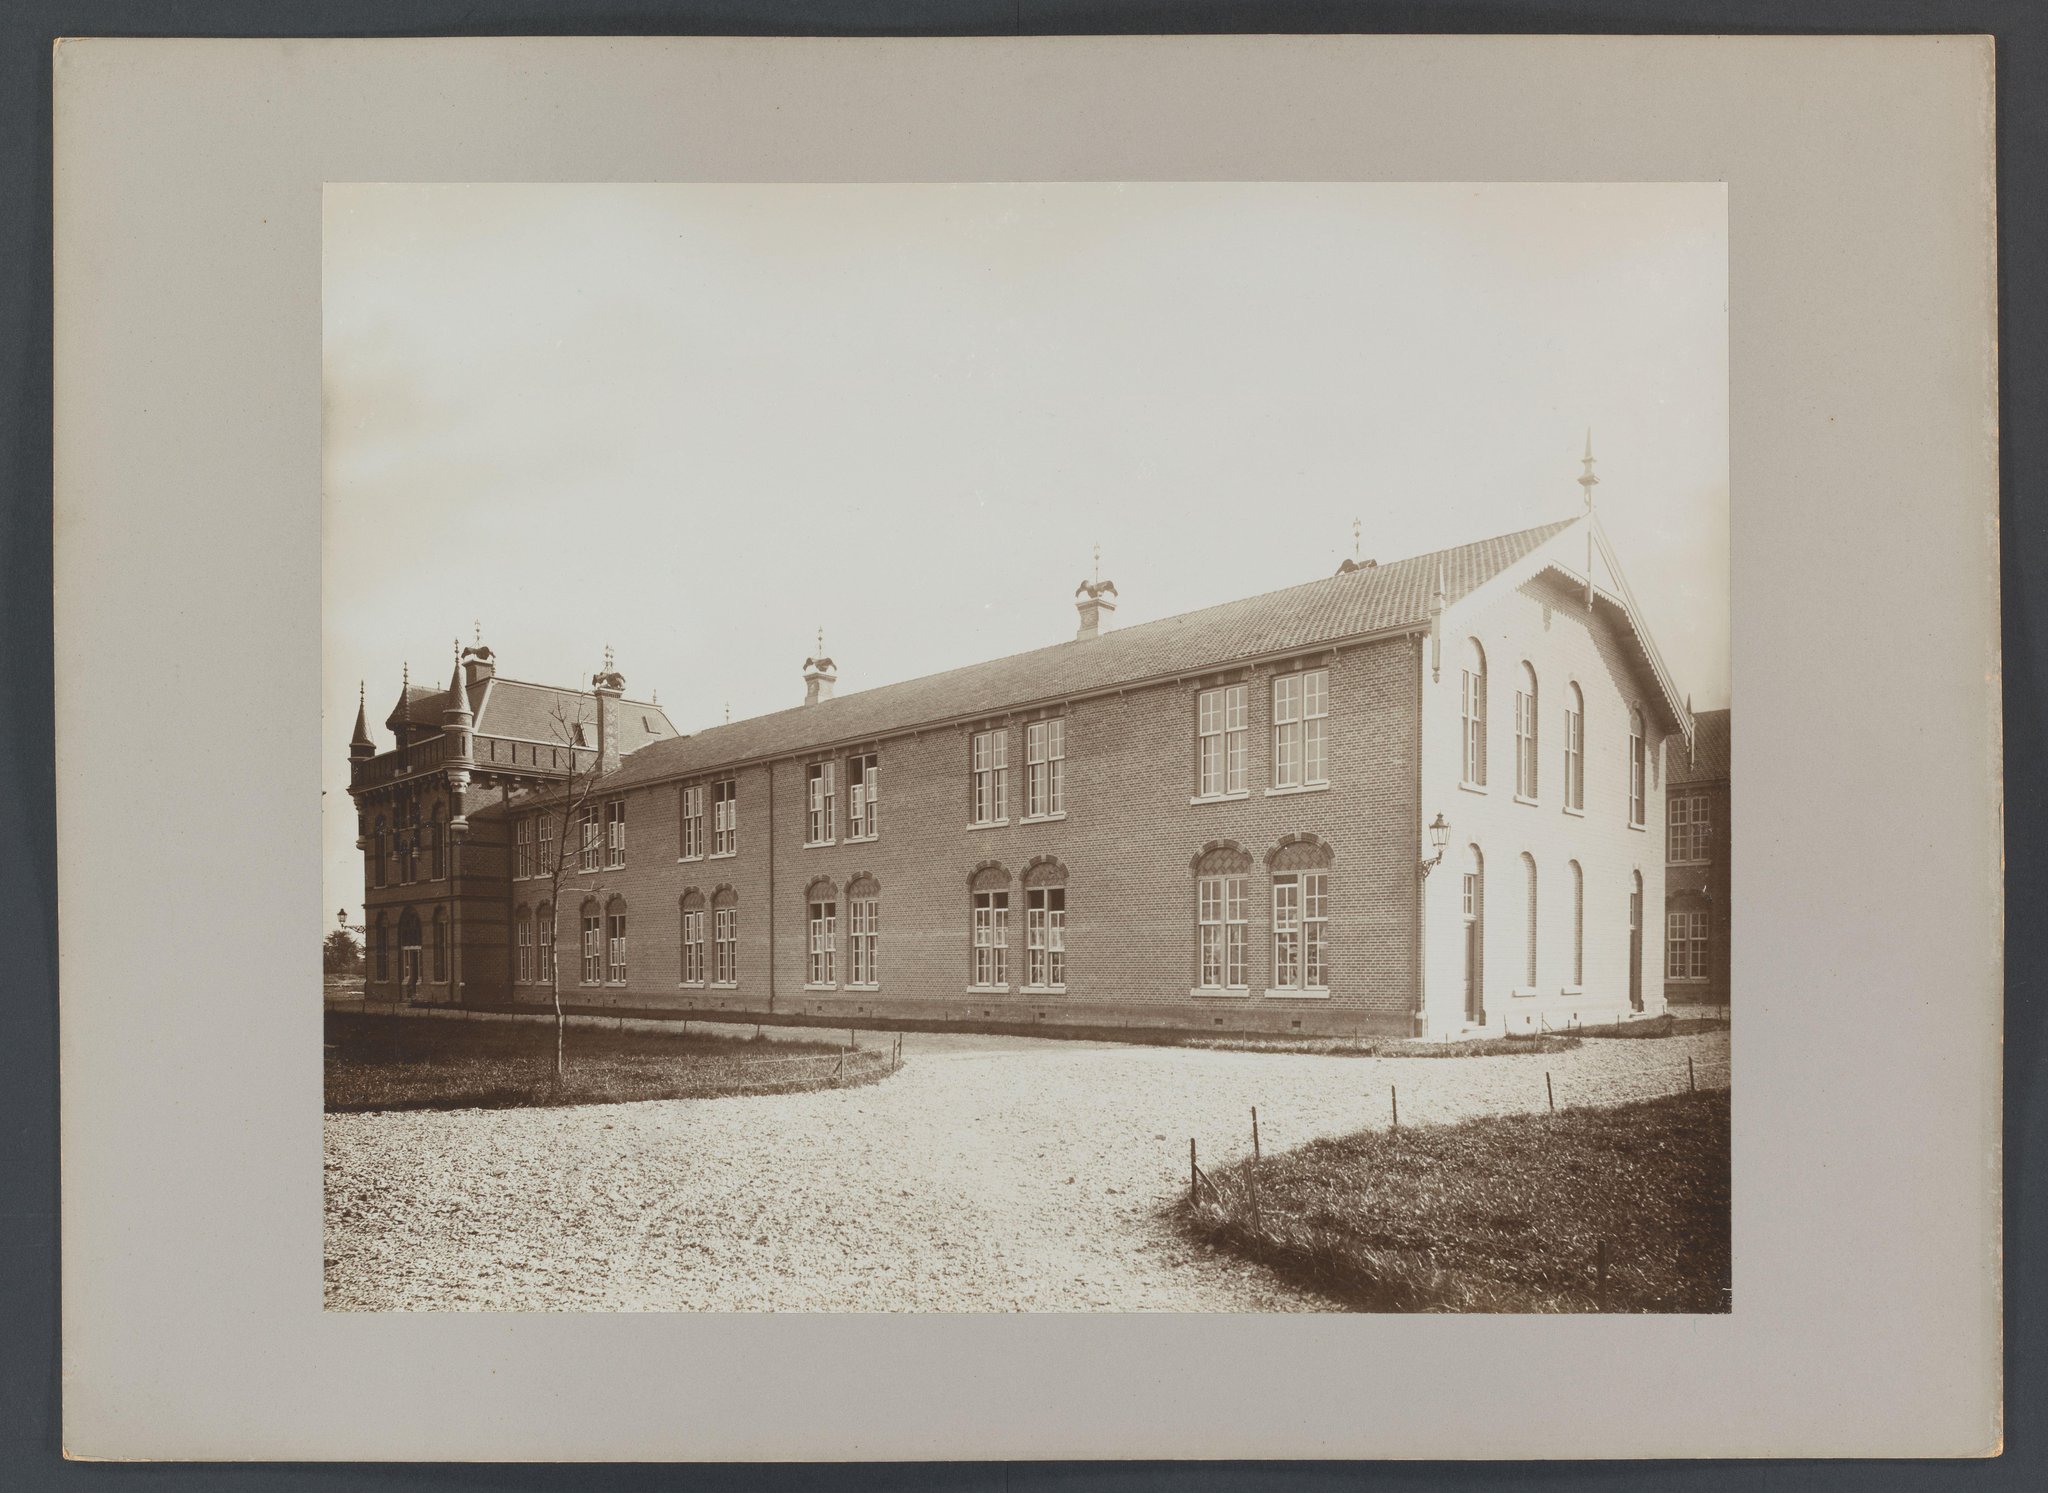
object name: photograph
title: Chassékazerne te Breda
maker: Anonymous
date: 1895-1899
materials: paper, cardboard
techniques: collodion silver print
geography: breda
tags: exterior ~ representation of a building